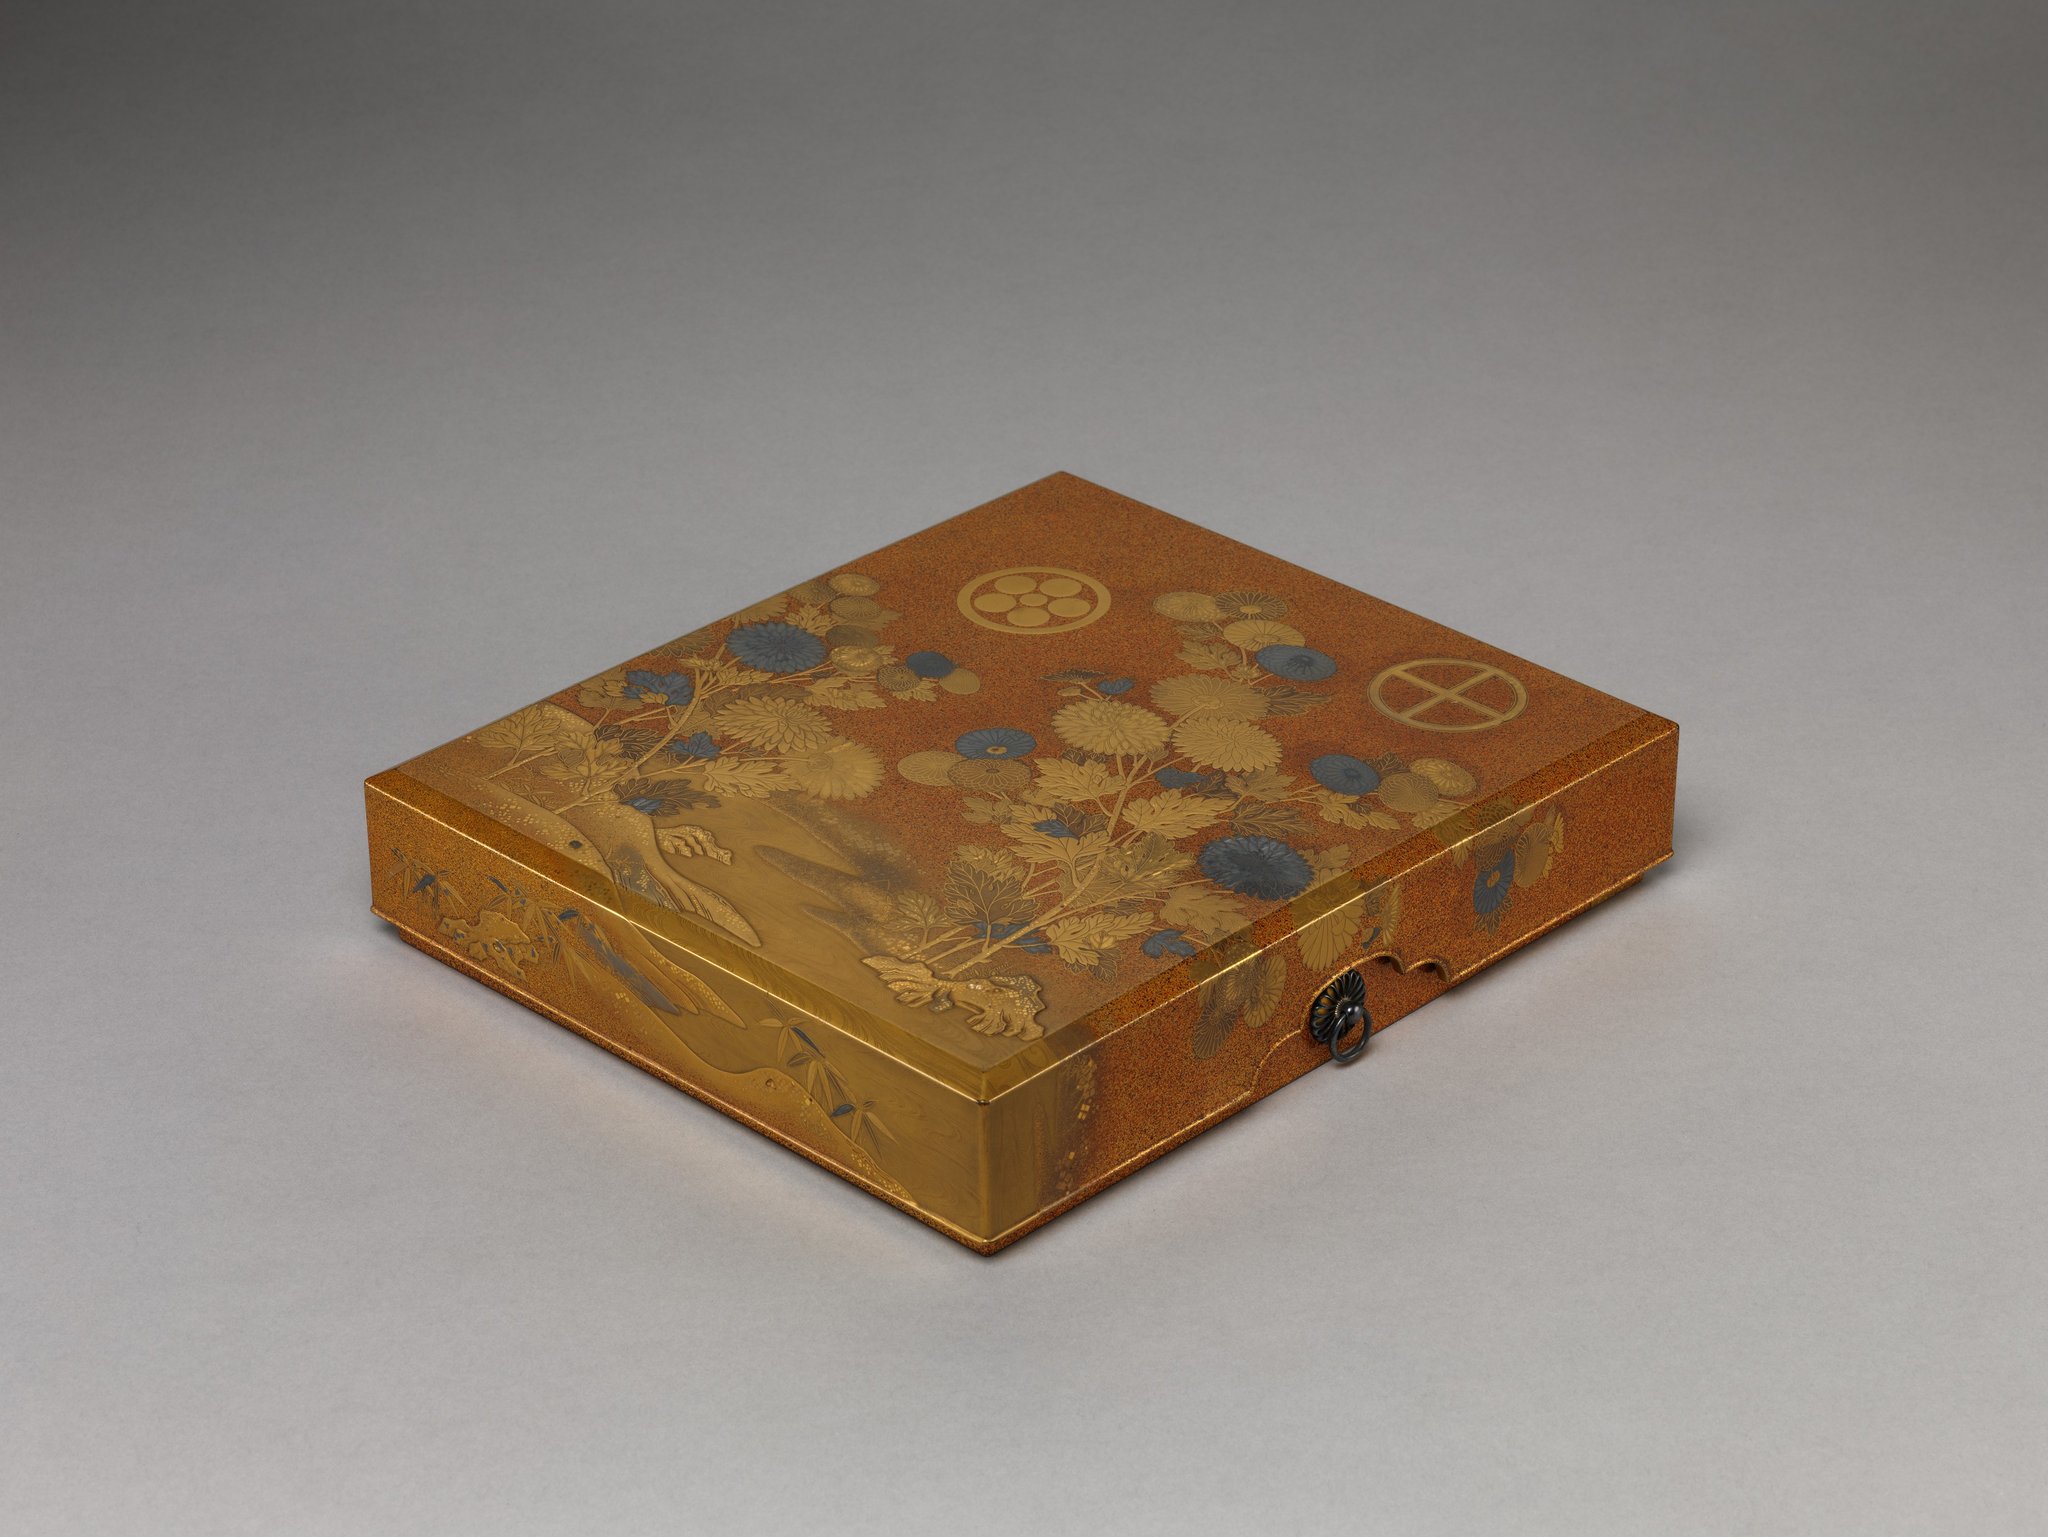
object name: box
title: Box with Design of Chrysanthemums by a Stream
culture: japanese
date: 1801-1900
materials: gold, lacquer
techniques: maki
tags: flowers